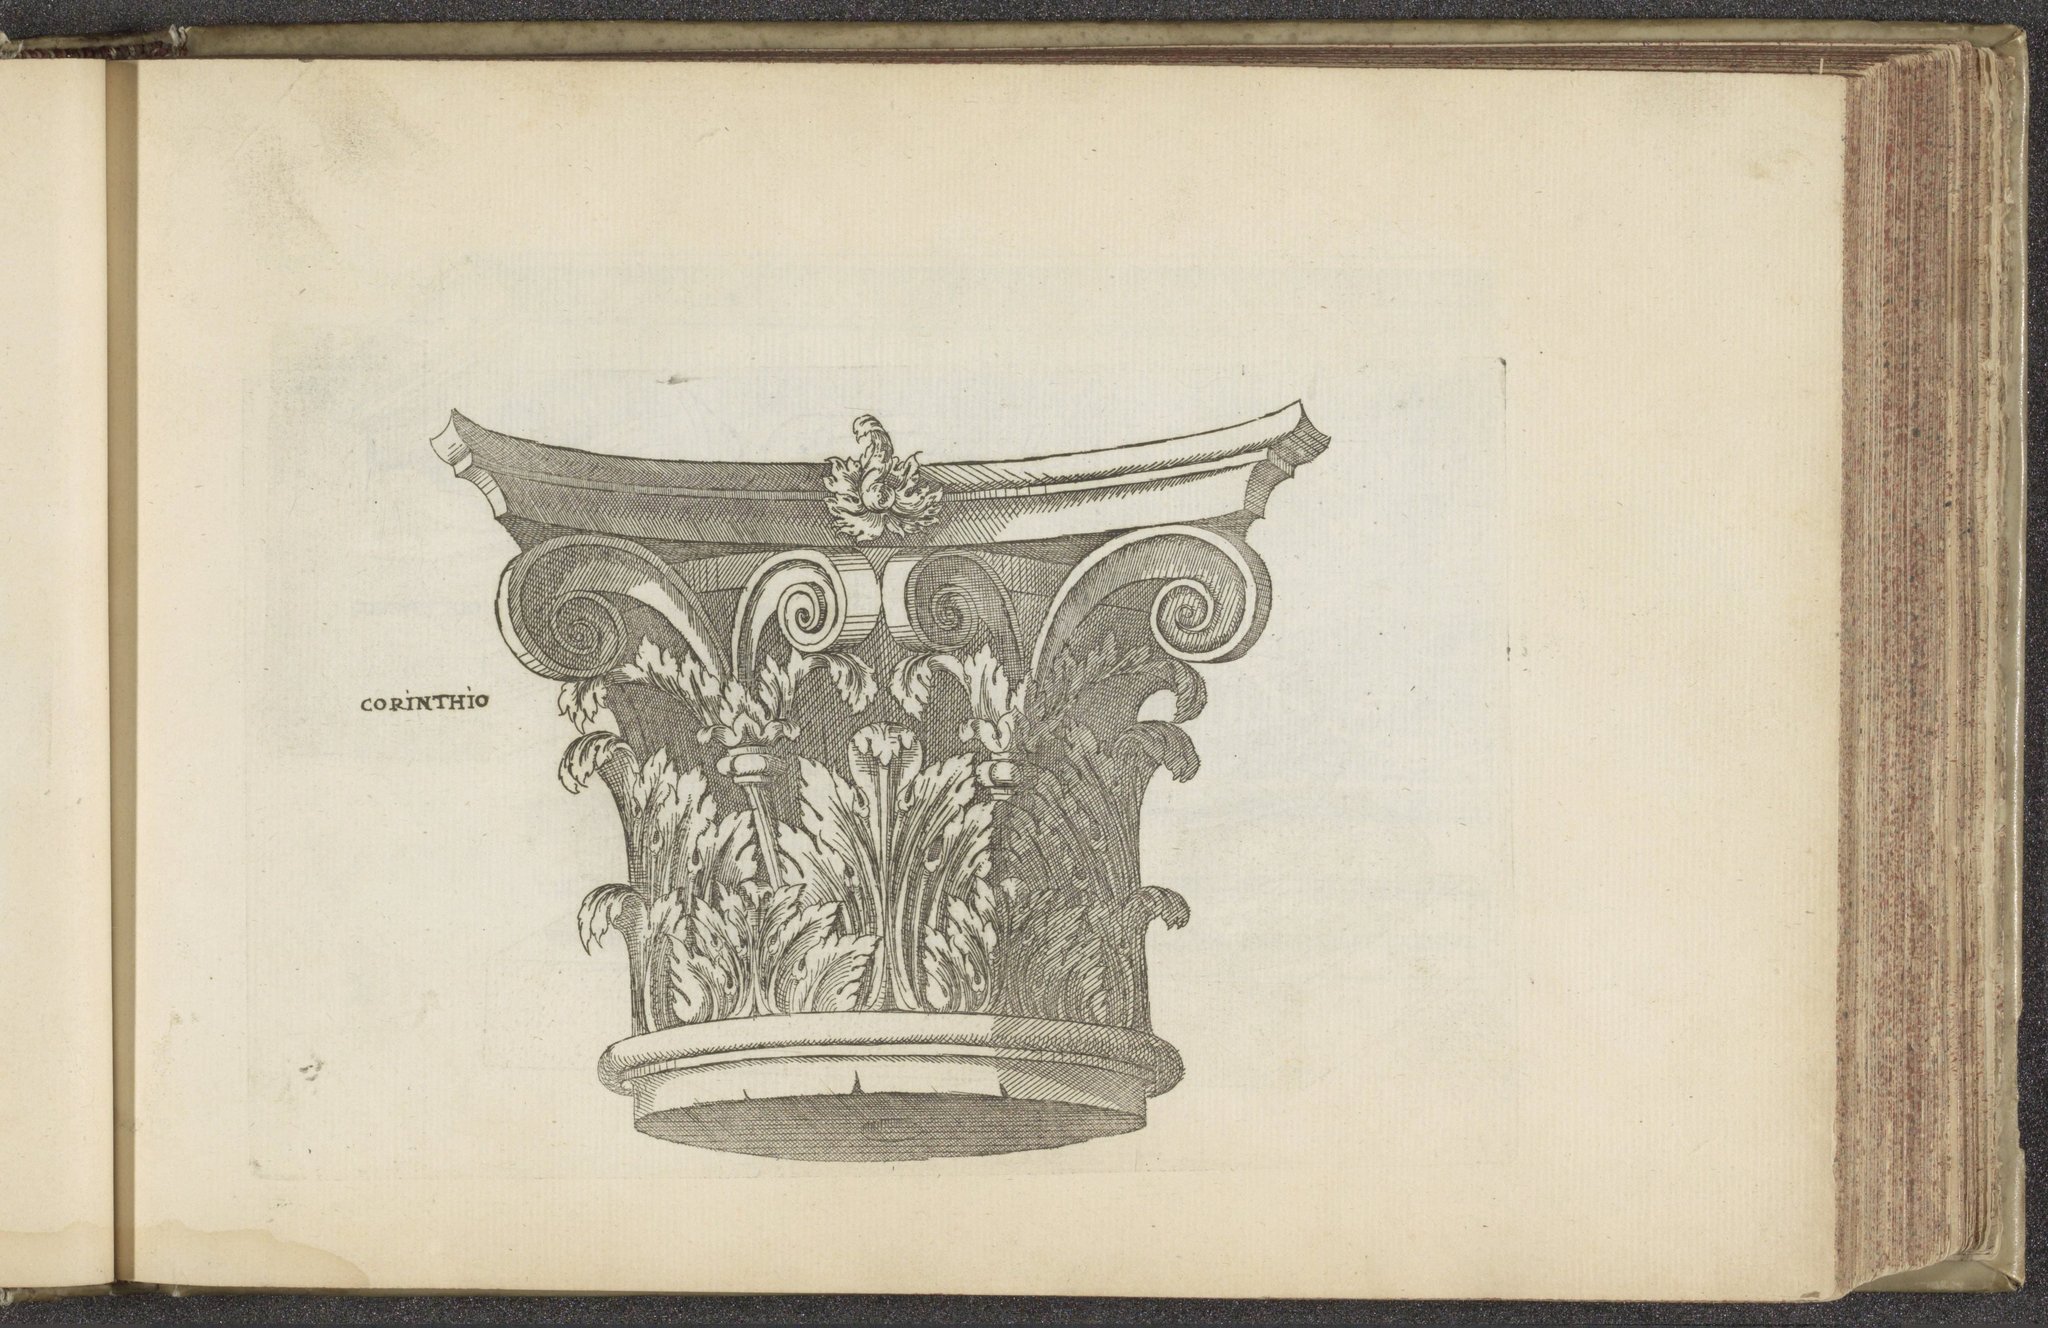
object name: album leaf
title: Kapiteel van de Korintische orde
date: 1601-1651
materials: paper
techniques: etching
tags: corinthian order ~ architecture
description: Kapiteel van de Korintische orde. Deze prent maakt deel uit van een album.